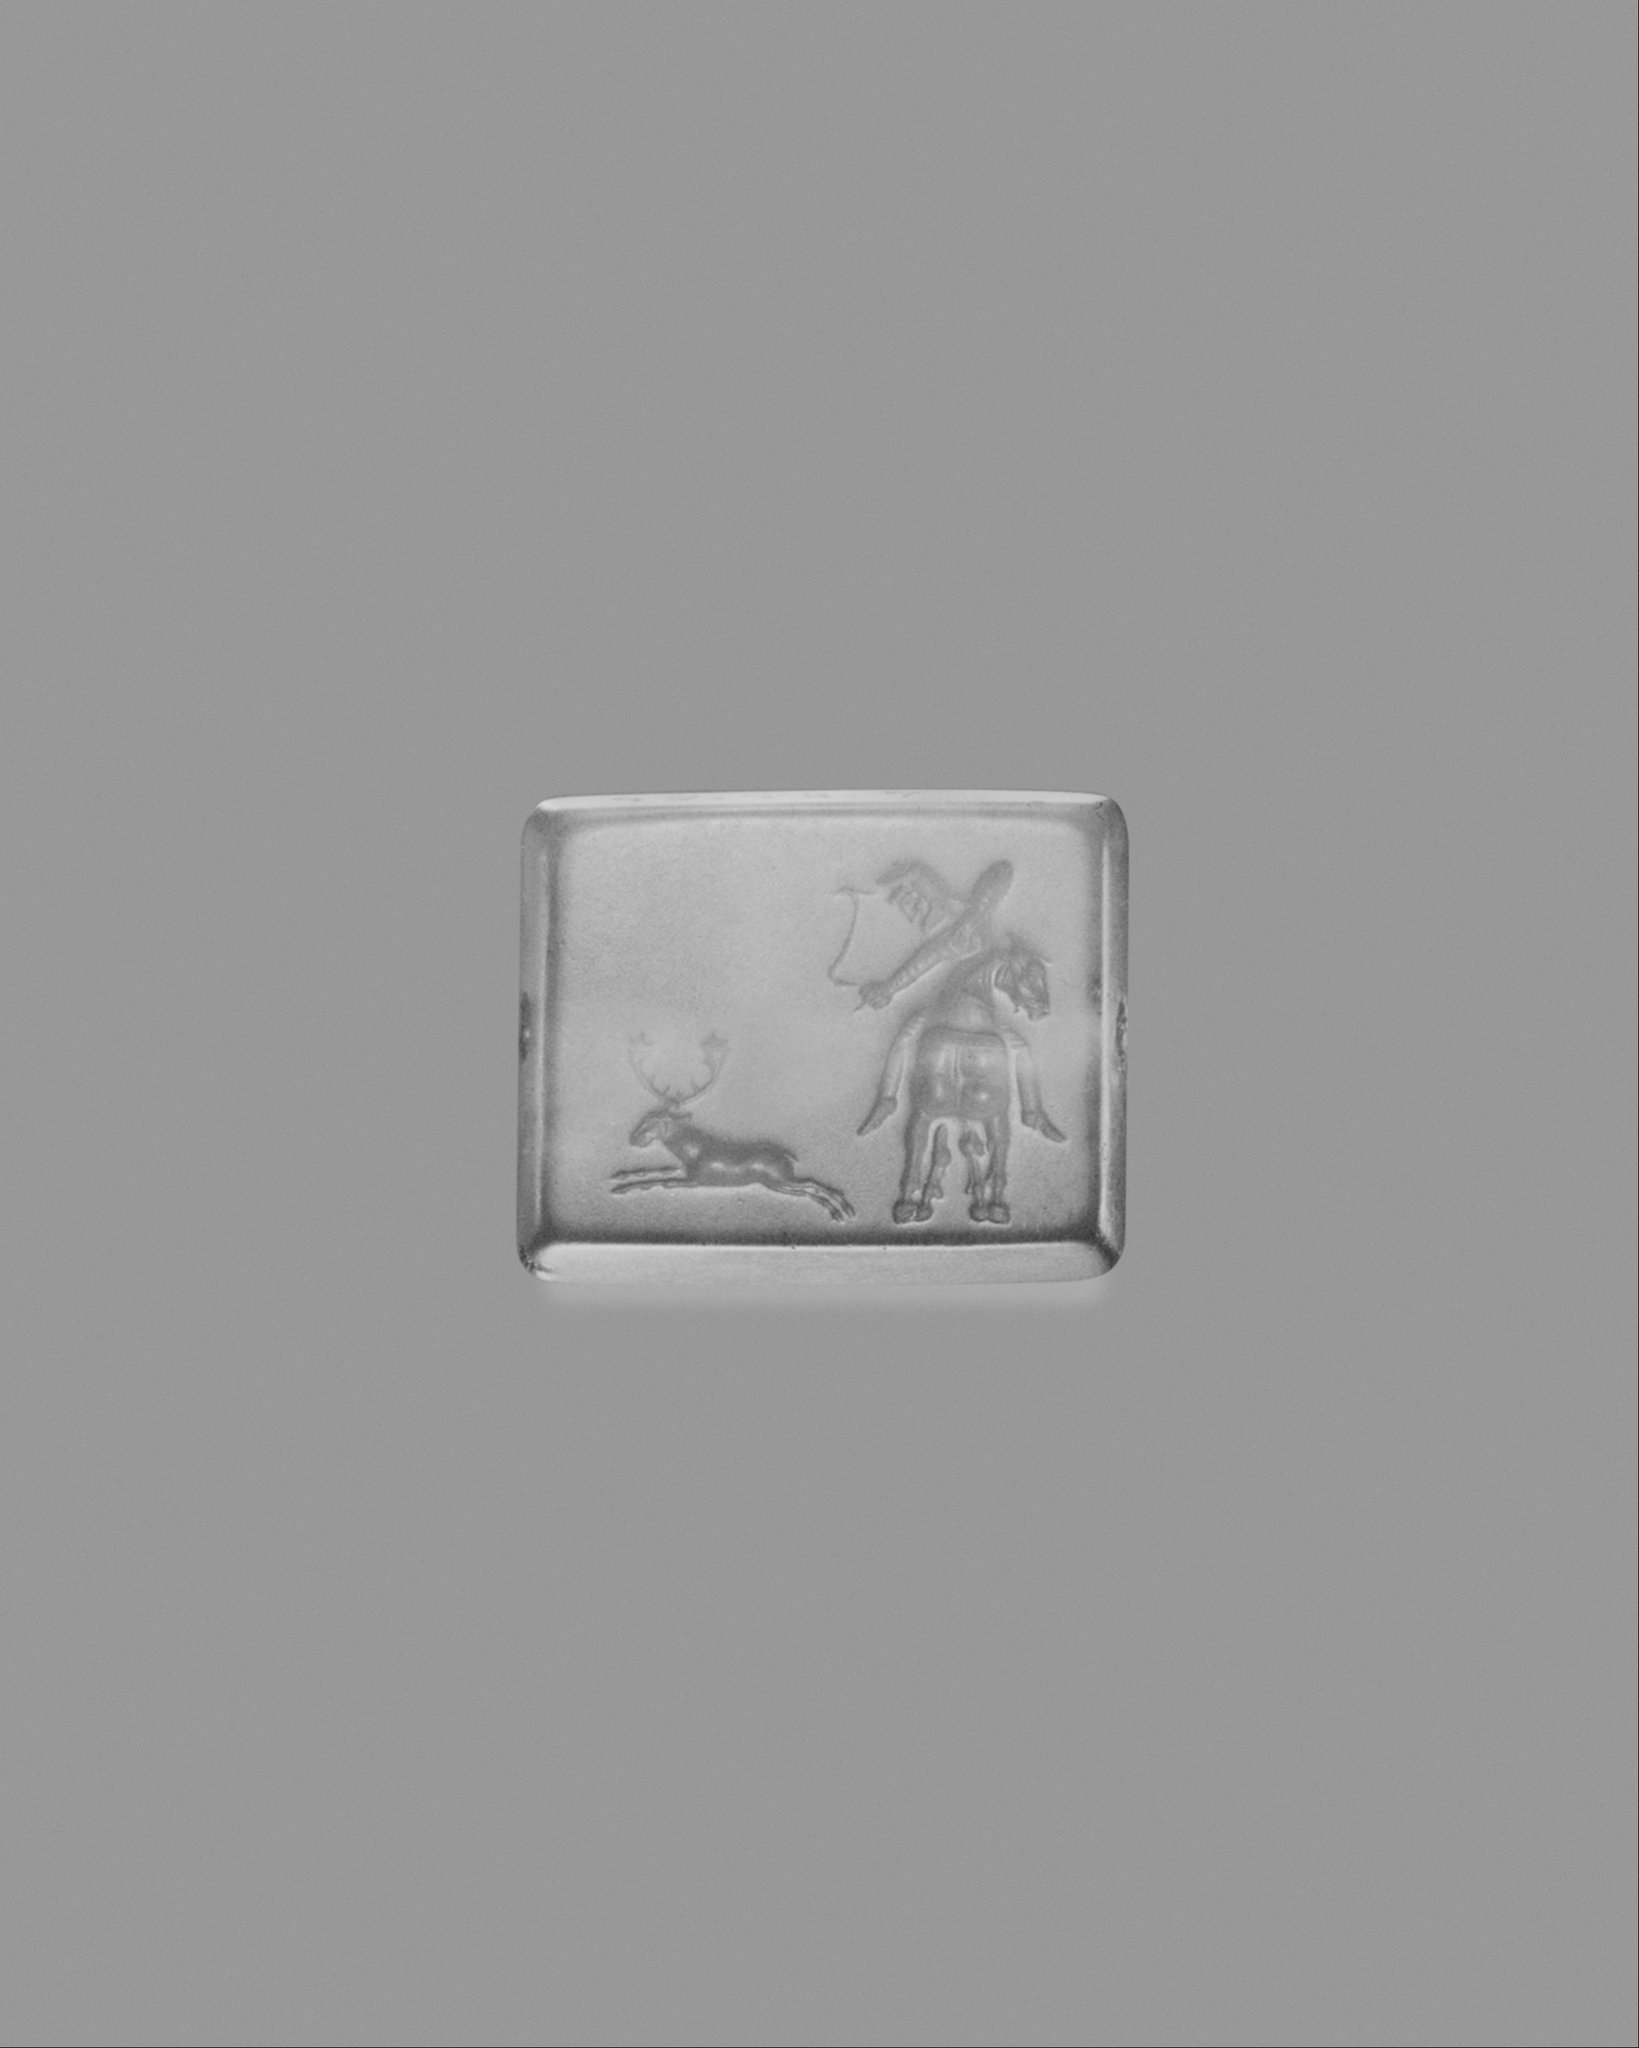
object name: intaglio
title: Faceted agate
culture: graeco-persian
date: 450-401 BCE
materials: stone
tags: men,hunting,deer,horses,lions